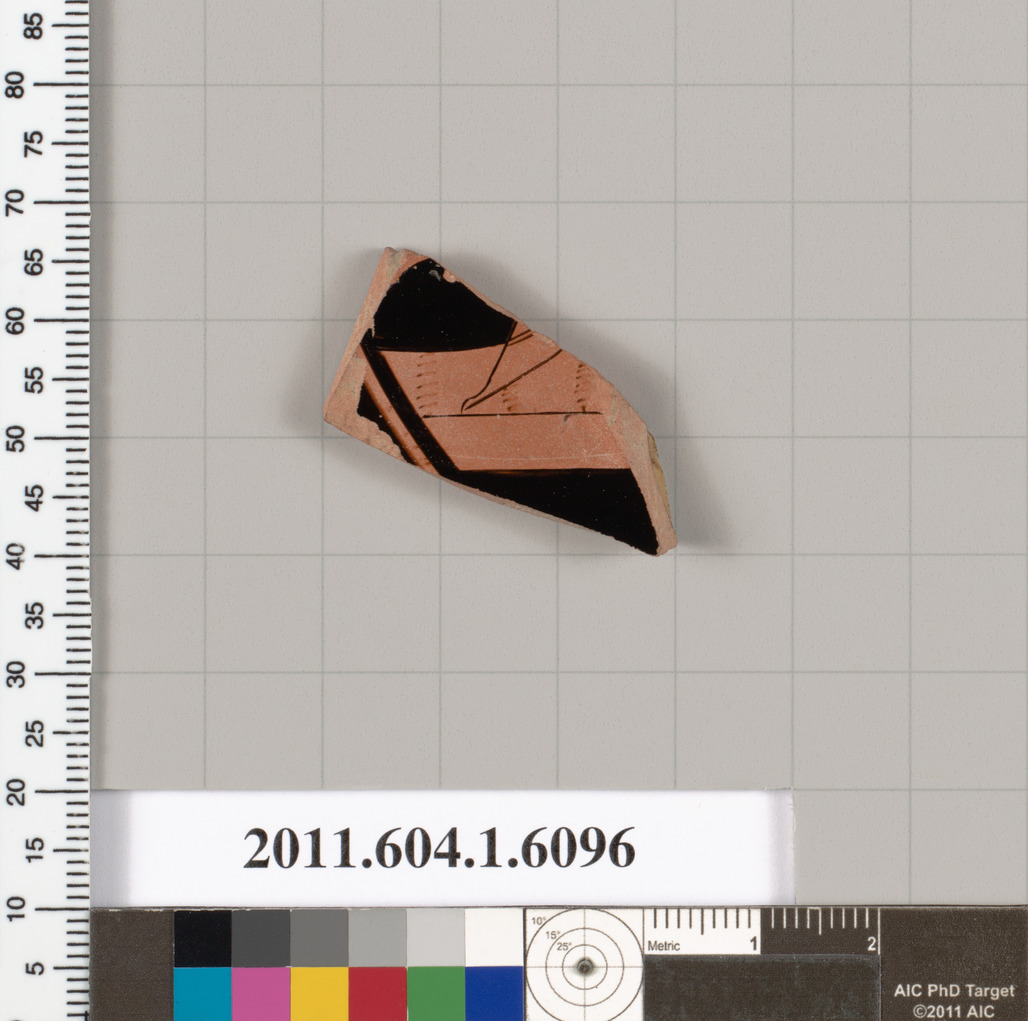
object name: kylix fragment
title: Terracotta fragment of a kylix (drinking cup)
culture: greek, attic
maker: apollodoros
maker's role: artist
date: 500-490 BCE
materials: terracotta